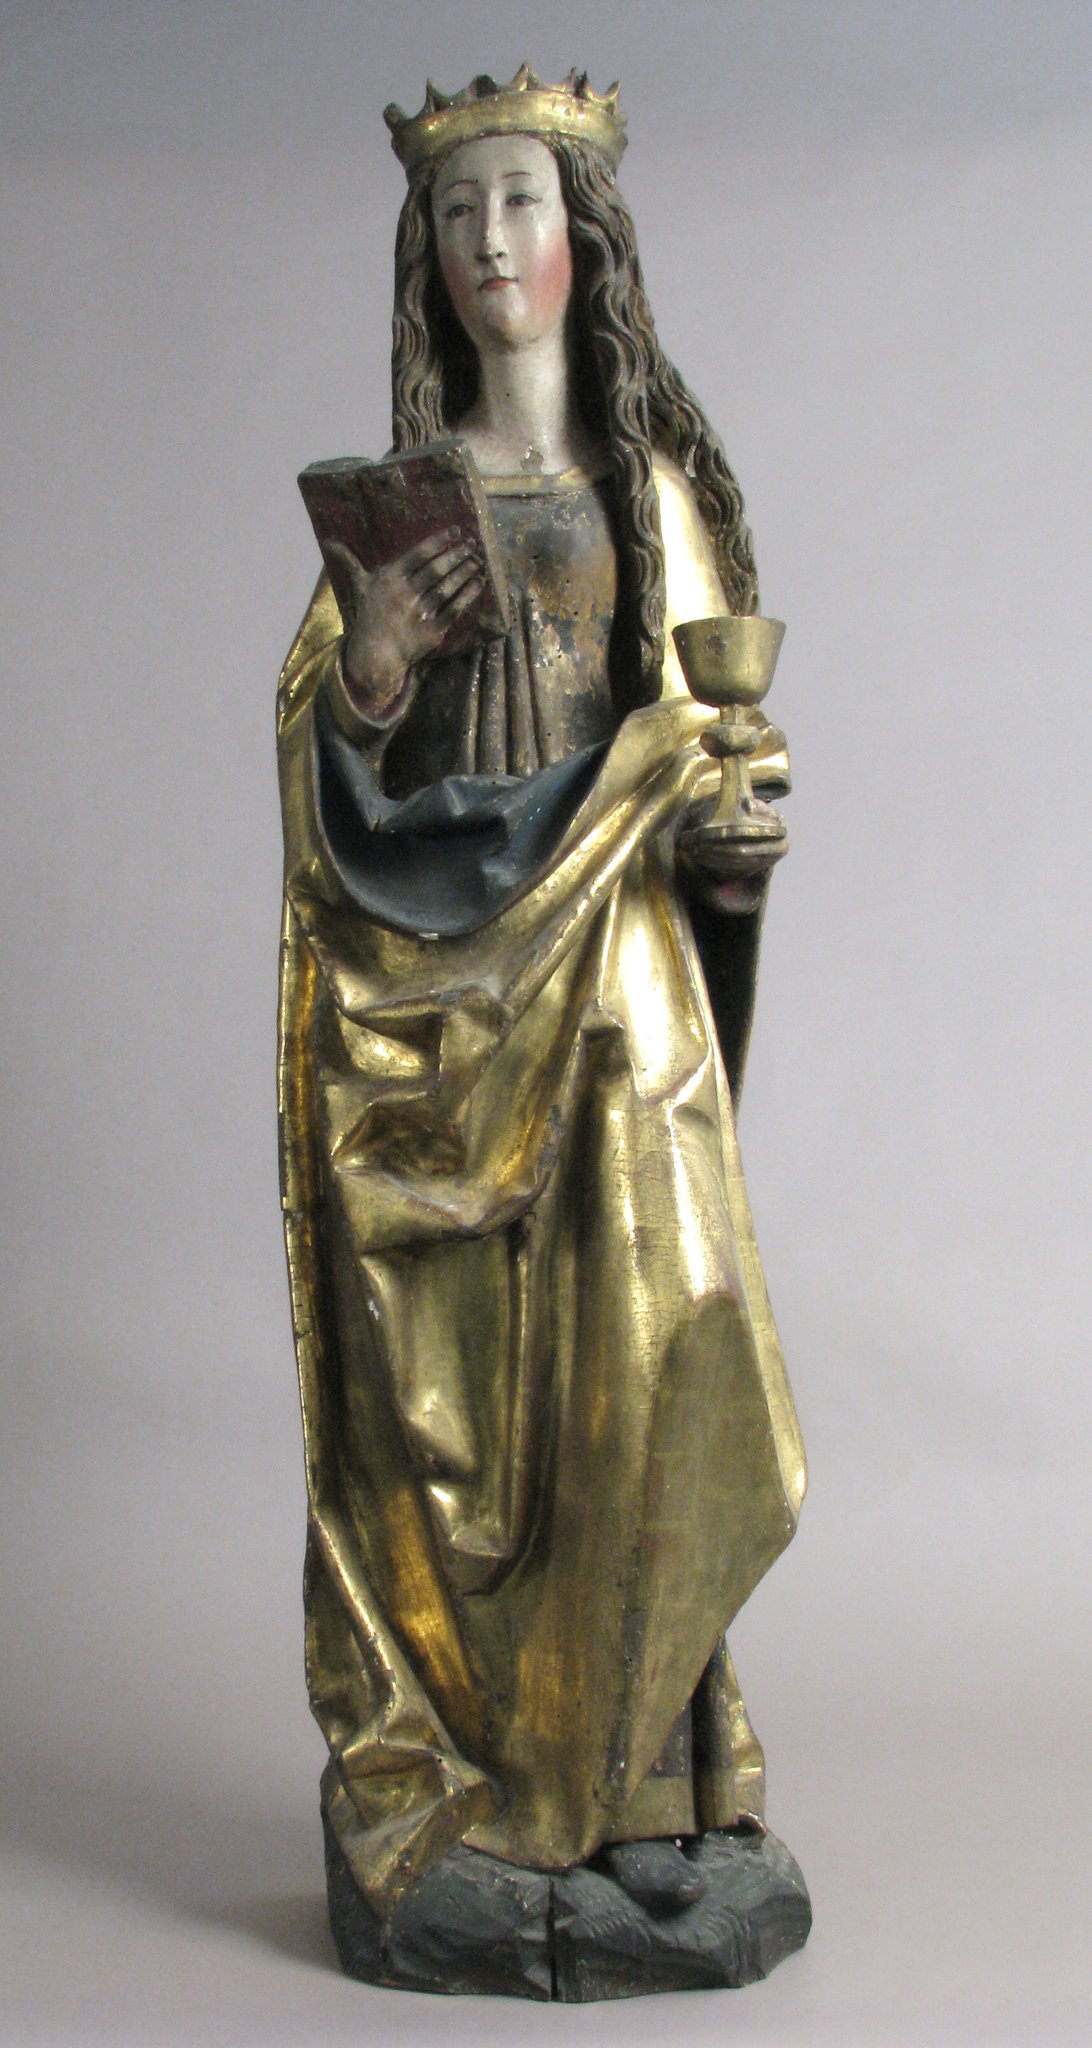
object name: statue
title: Saint Barbara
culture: german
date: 1401-1600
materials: paint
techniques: gilding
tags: women